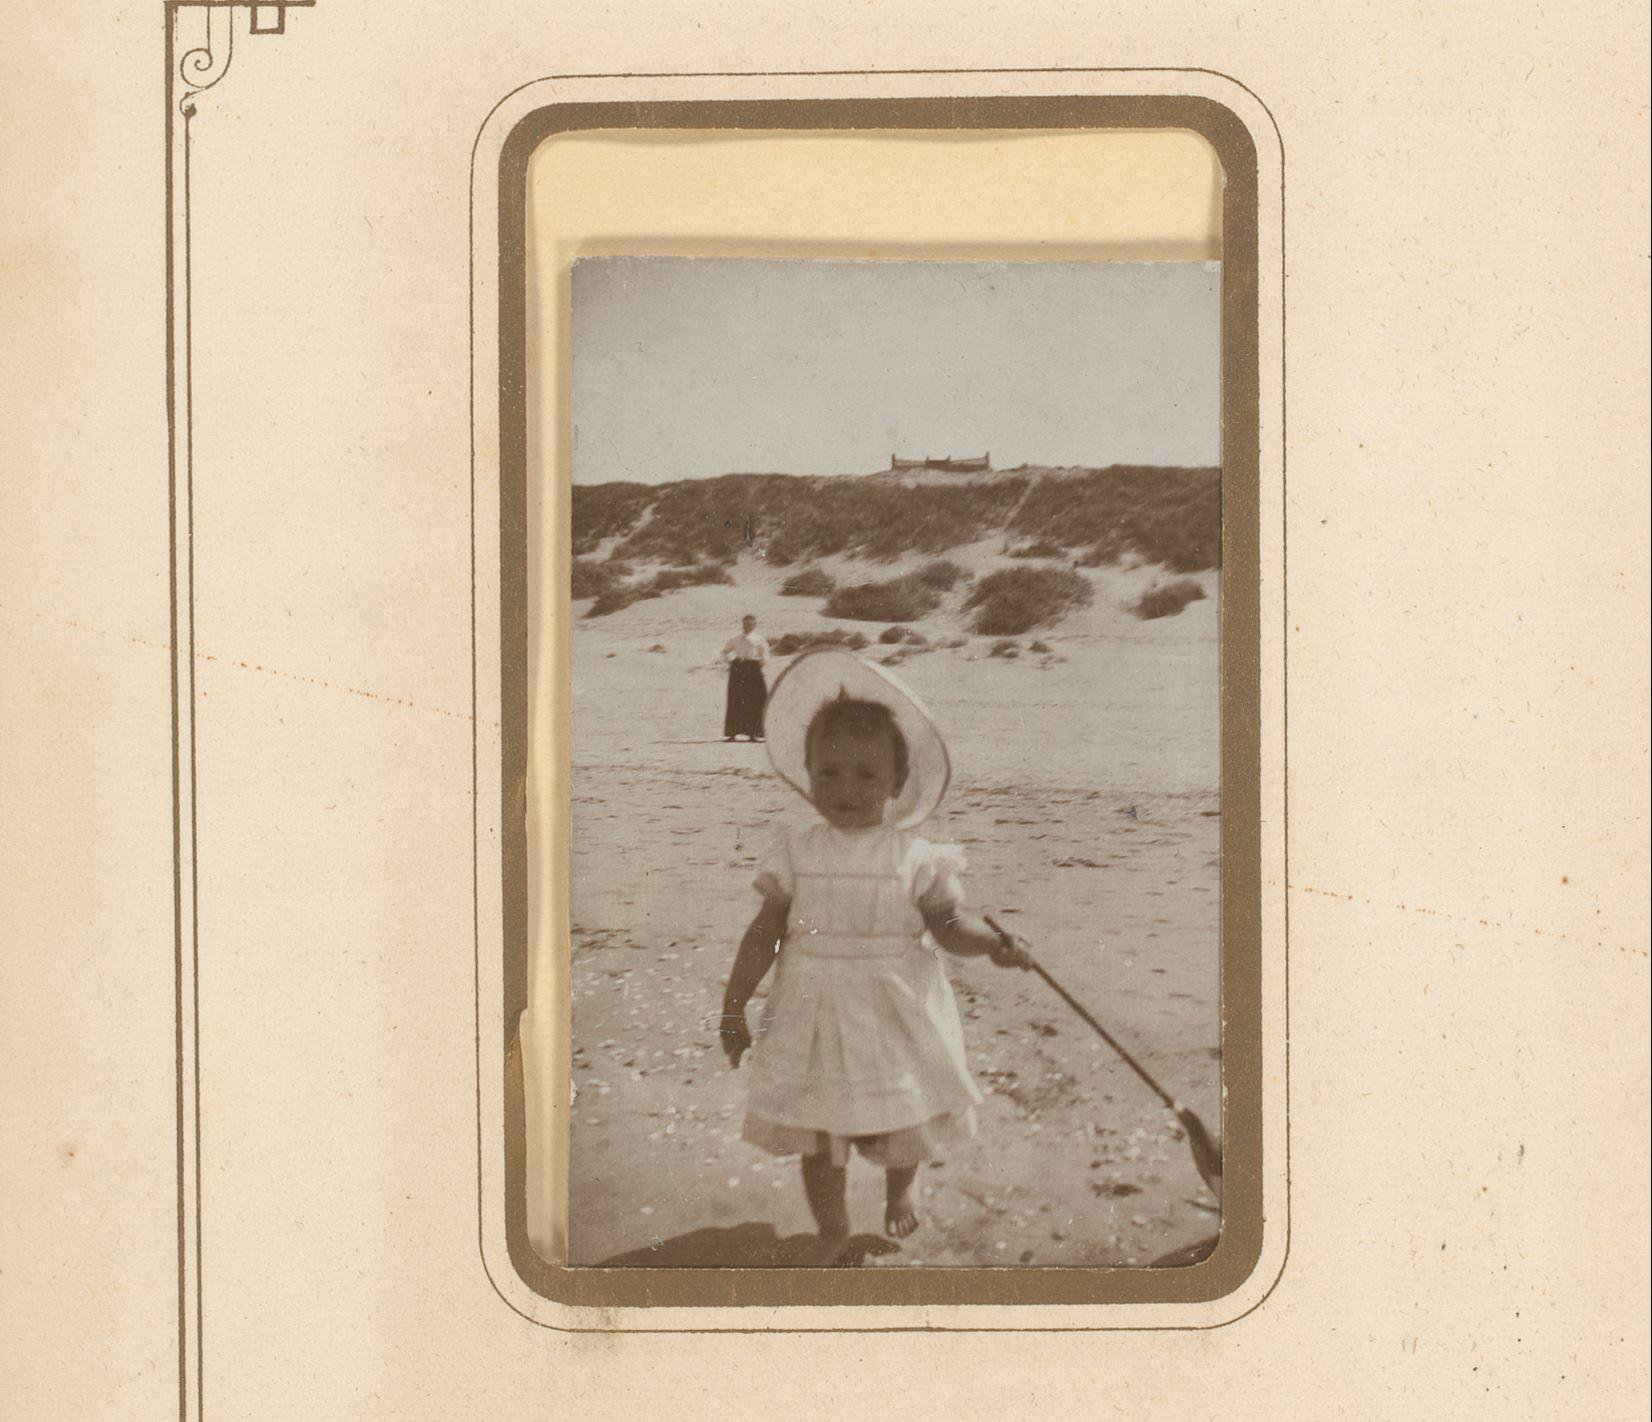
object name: album leaf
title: Peuter op het strand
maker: Anonymous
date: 1890-1920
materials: cardboard, photographic support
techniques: collodion silver print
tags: beach (as place of recreation), toddler